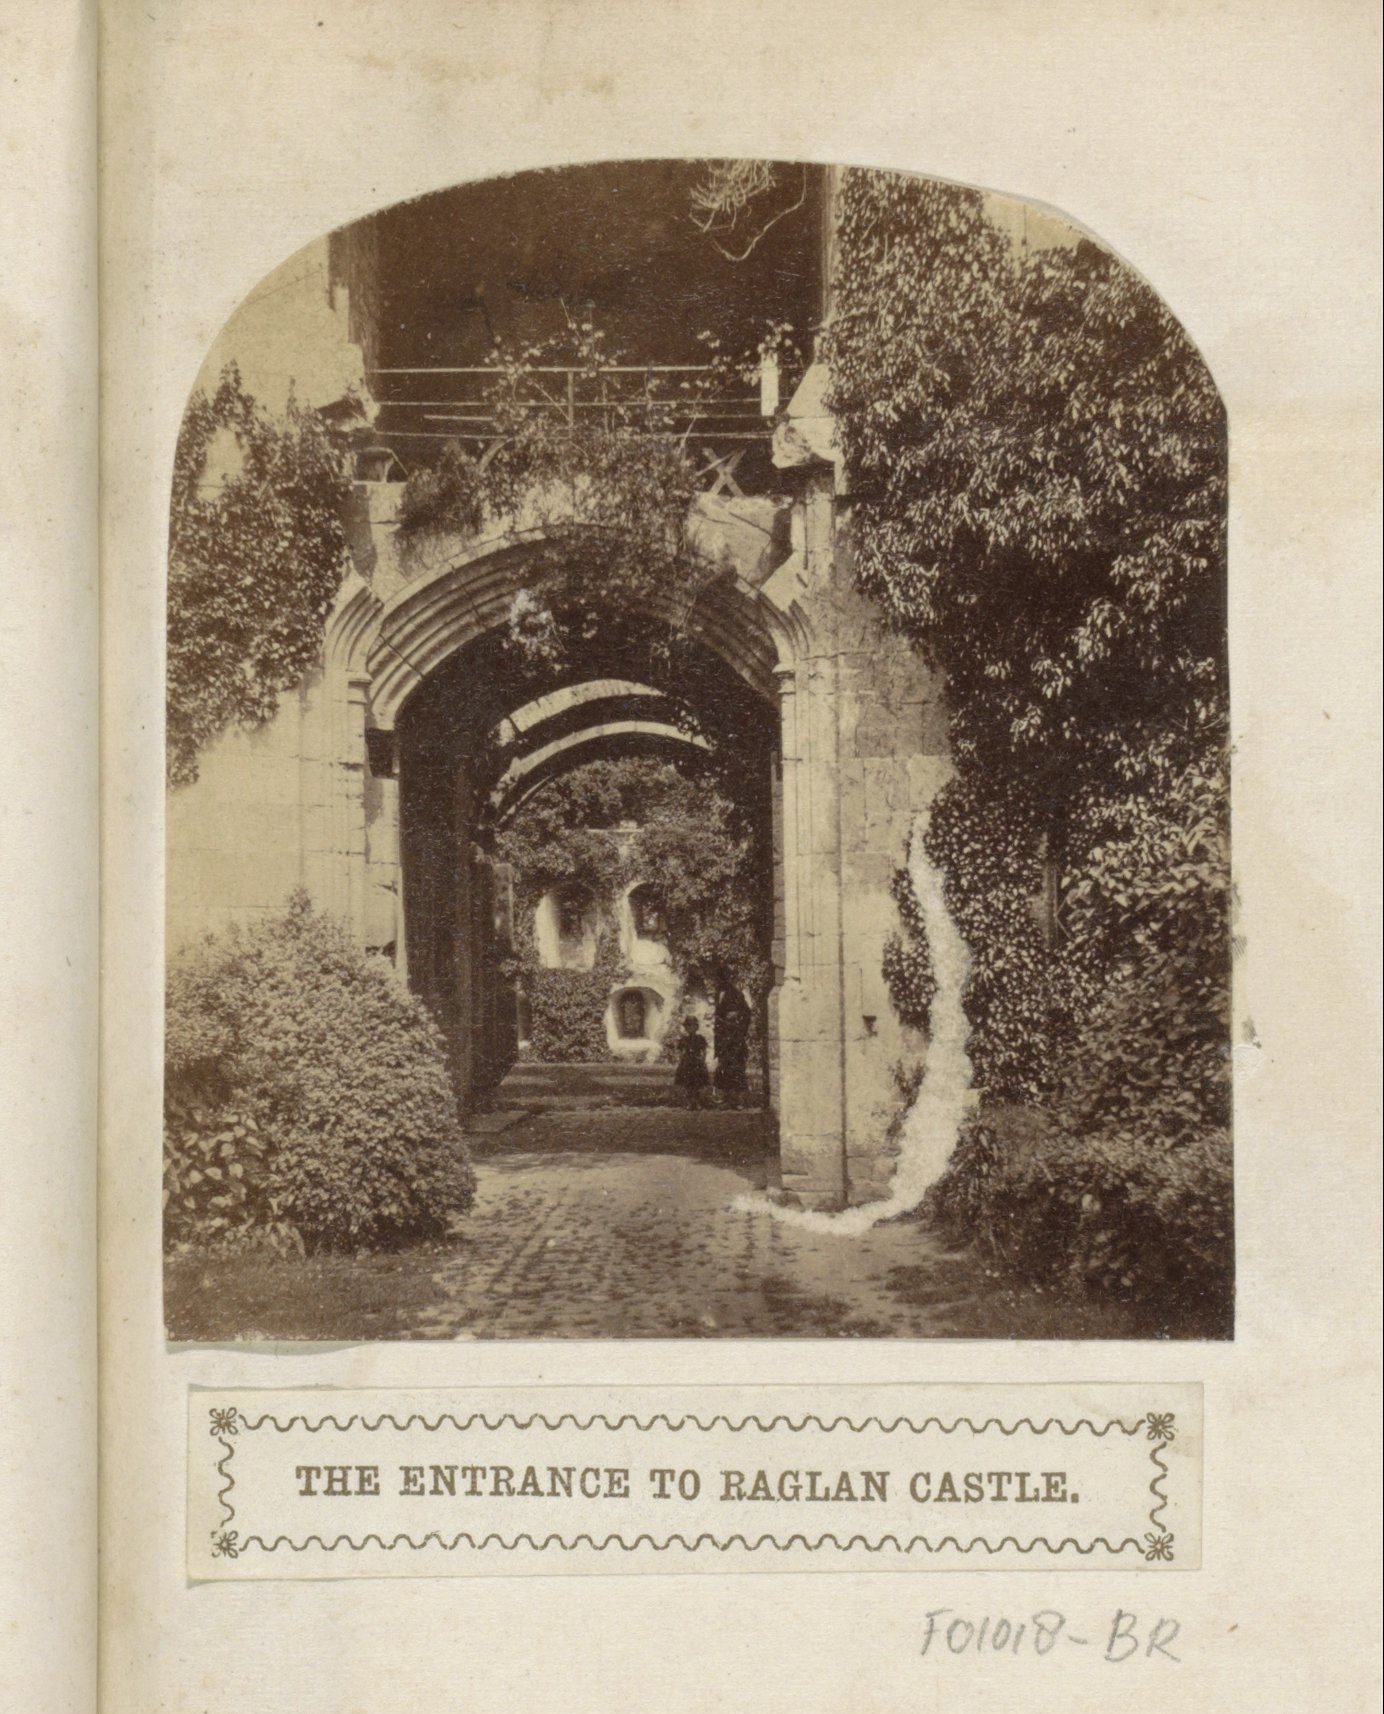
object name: photograph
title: The Entrance to Raglan Castle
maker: Anonymous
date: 1860-1870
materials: paper, photographic support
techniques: albumen print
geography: raglan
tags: castle, gate, entrance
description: Onderdeel van Engels familiealbum met foto's van personen, reizen, cricket en kunstwerken.